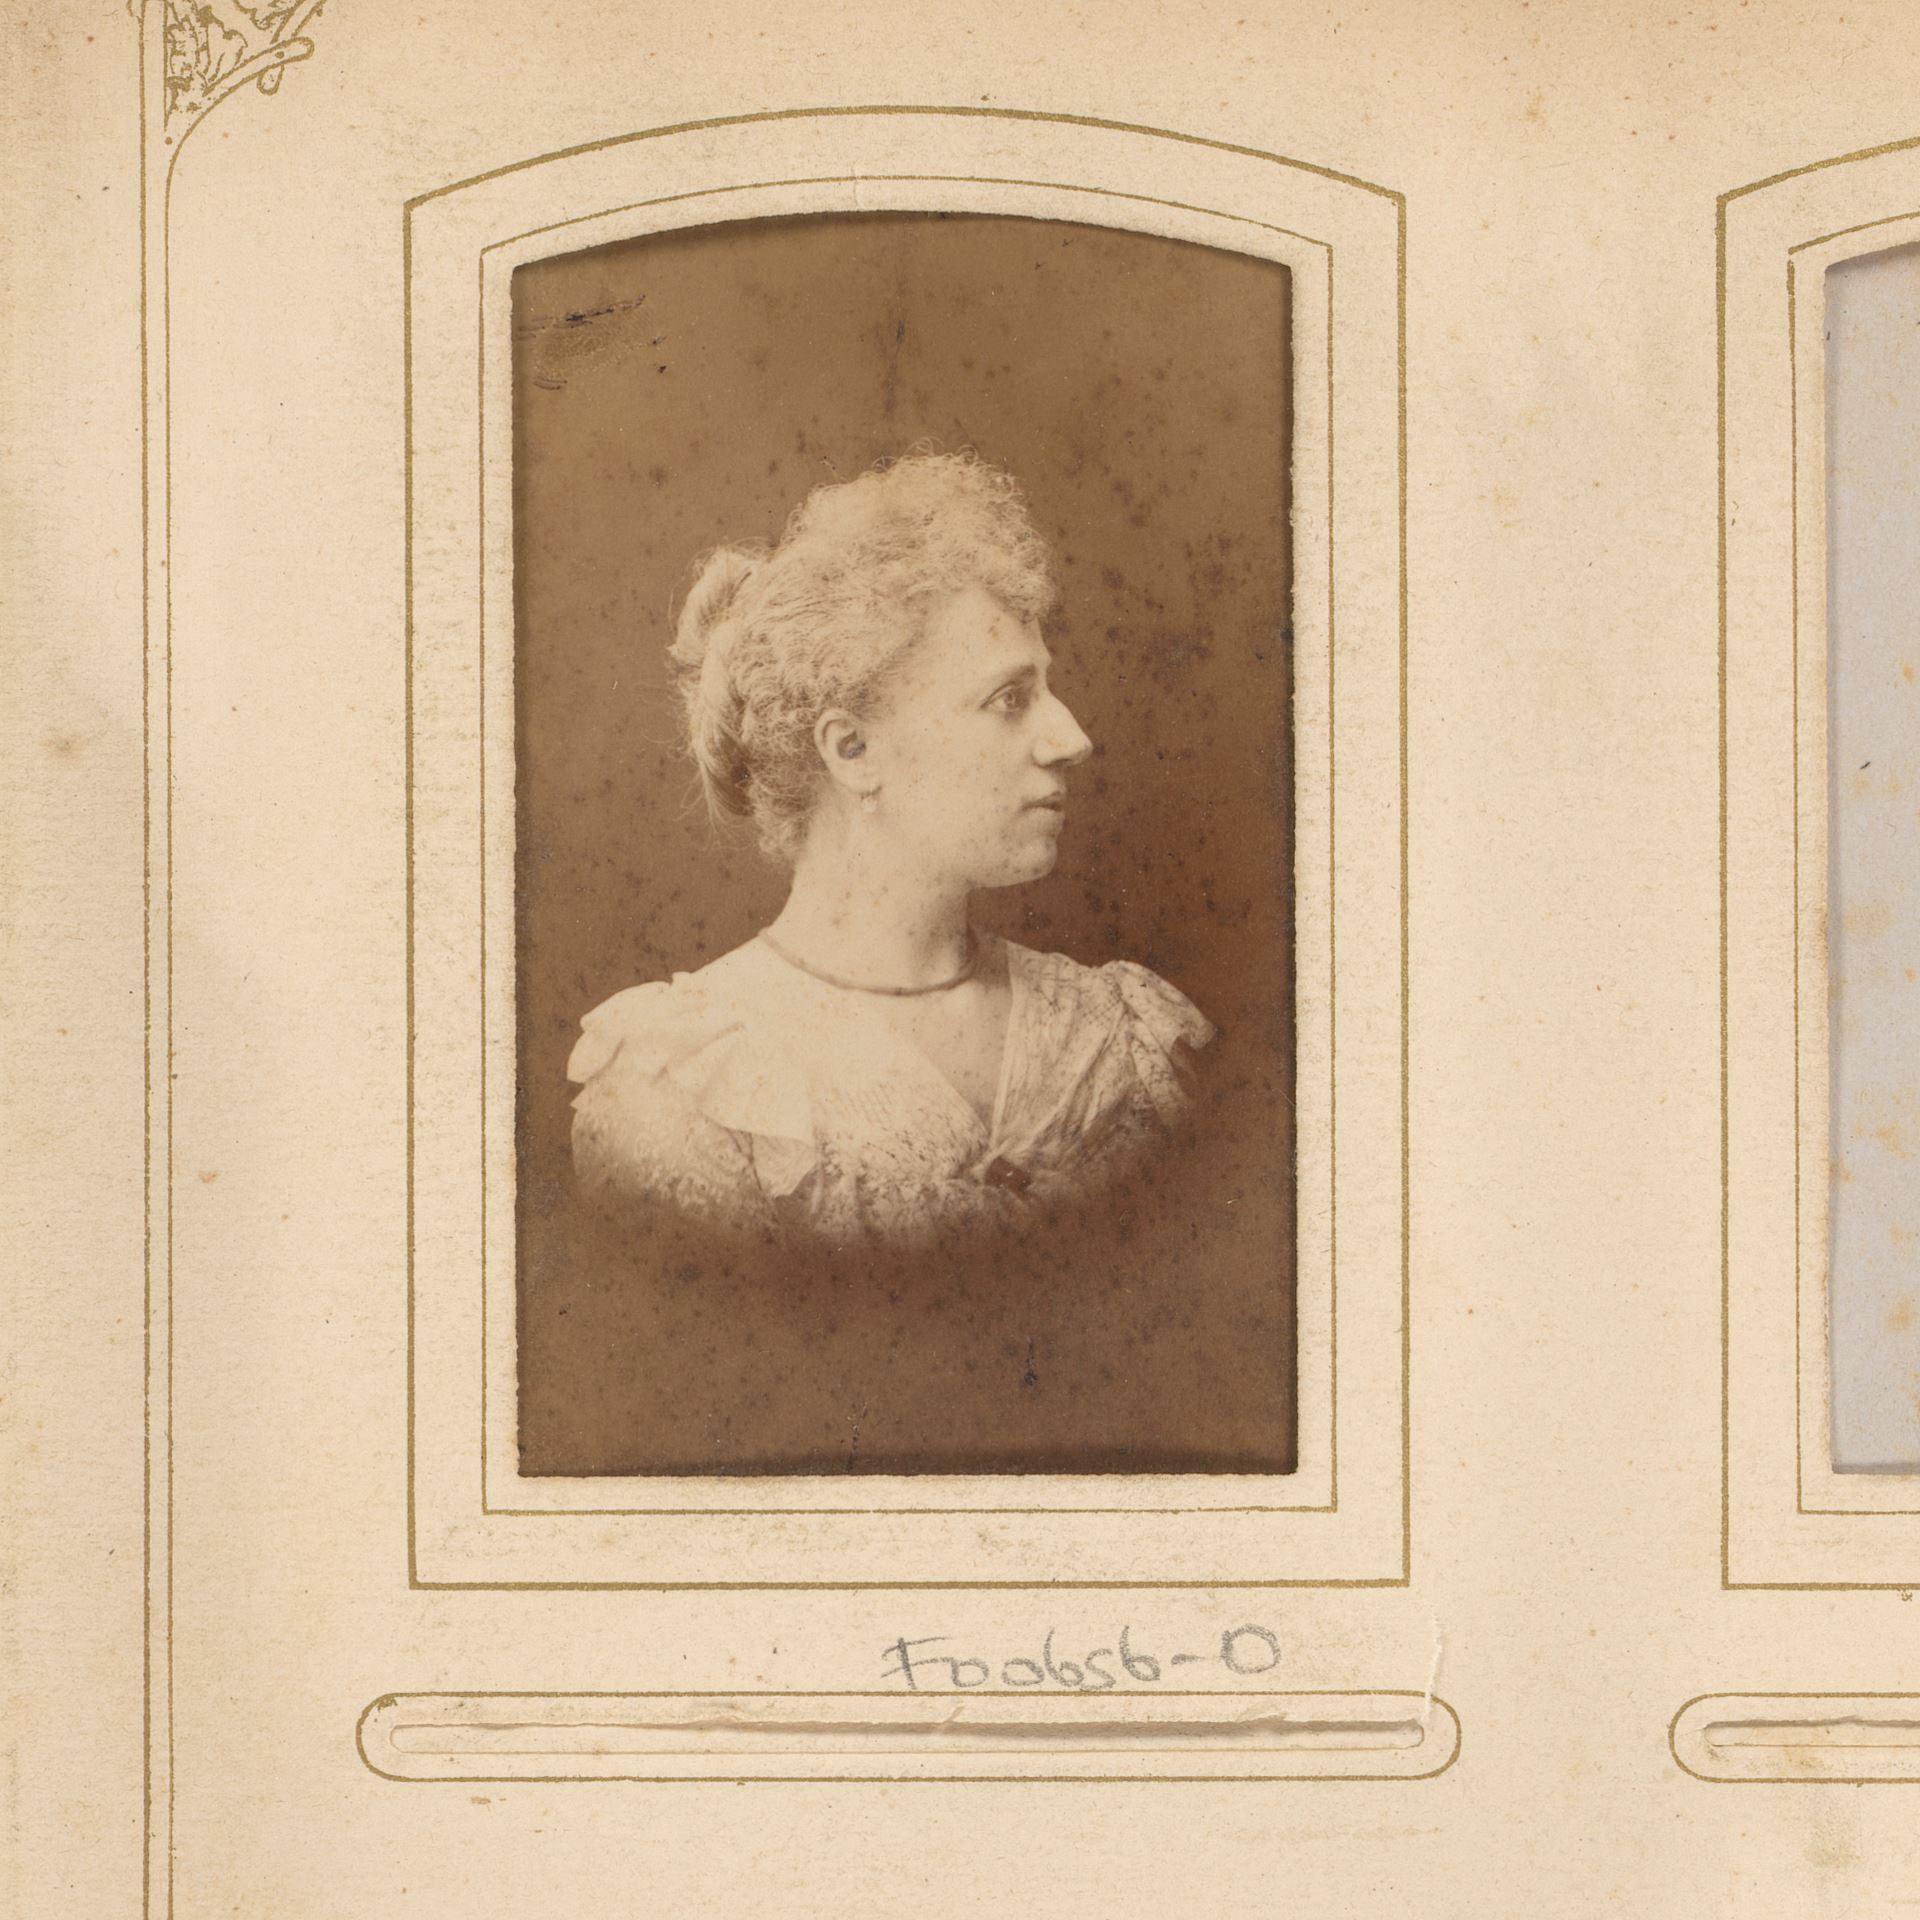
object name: carte de visite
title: Portret van een vrouw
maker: Anonymous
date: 1850-1900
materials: cardboard, photographic support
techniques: albumen print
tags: historical persons - bb - woman